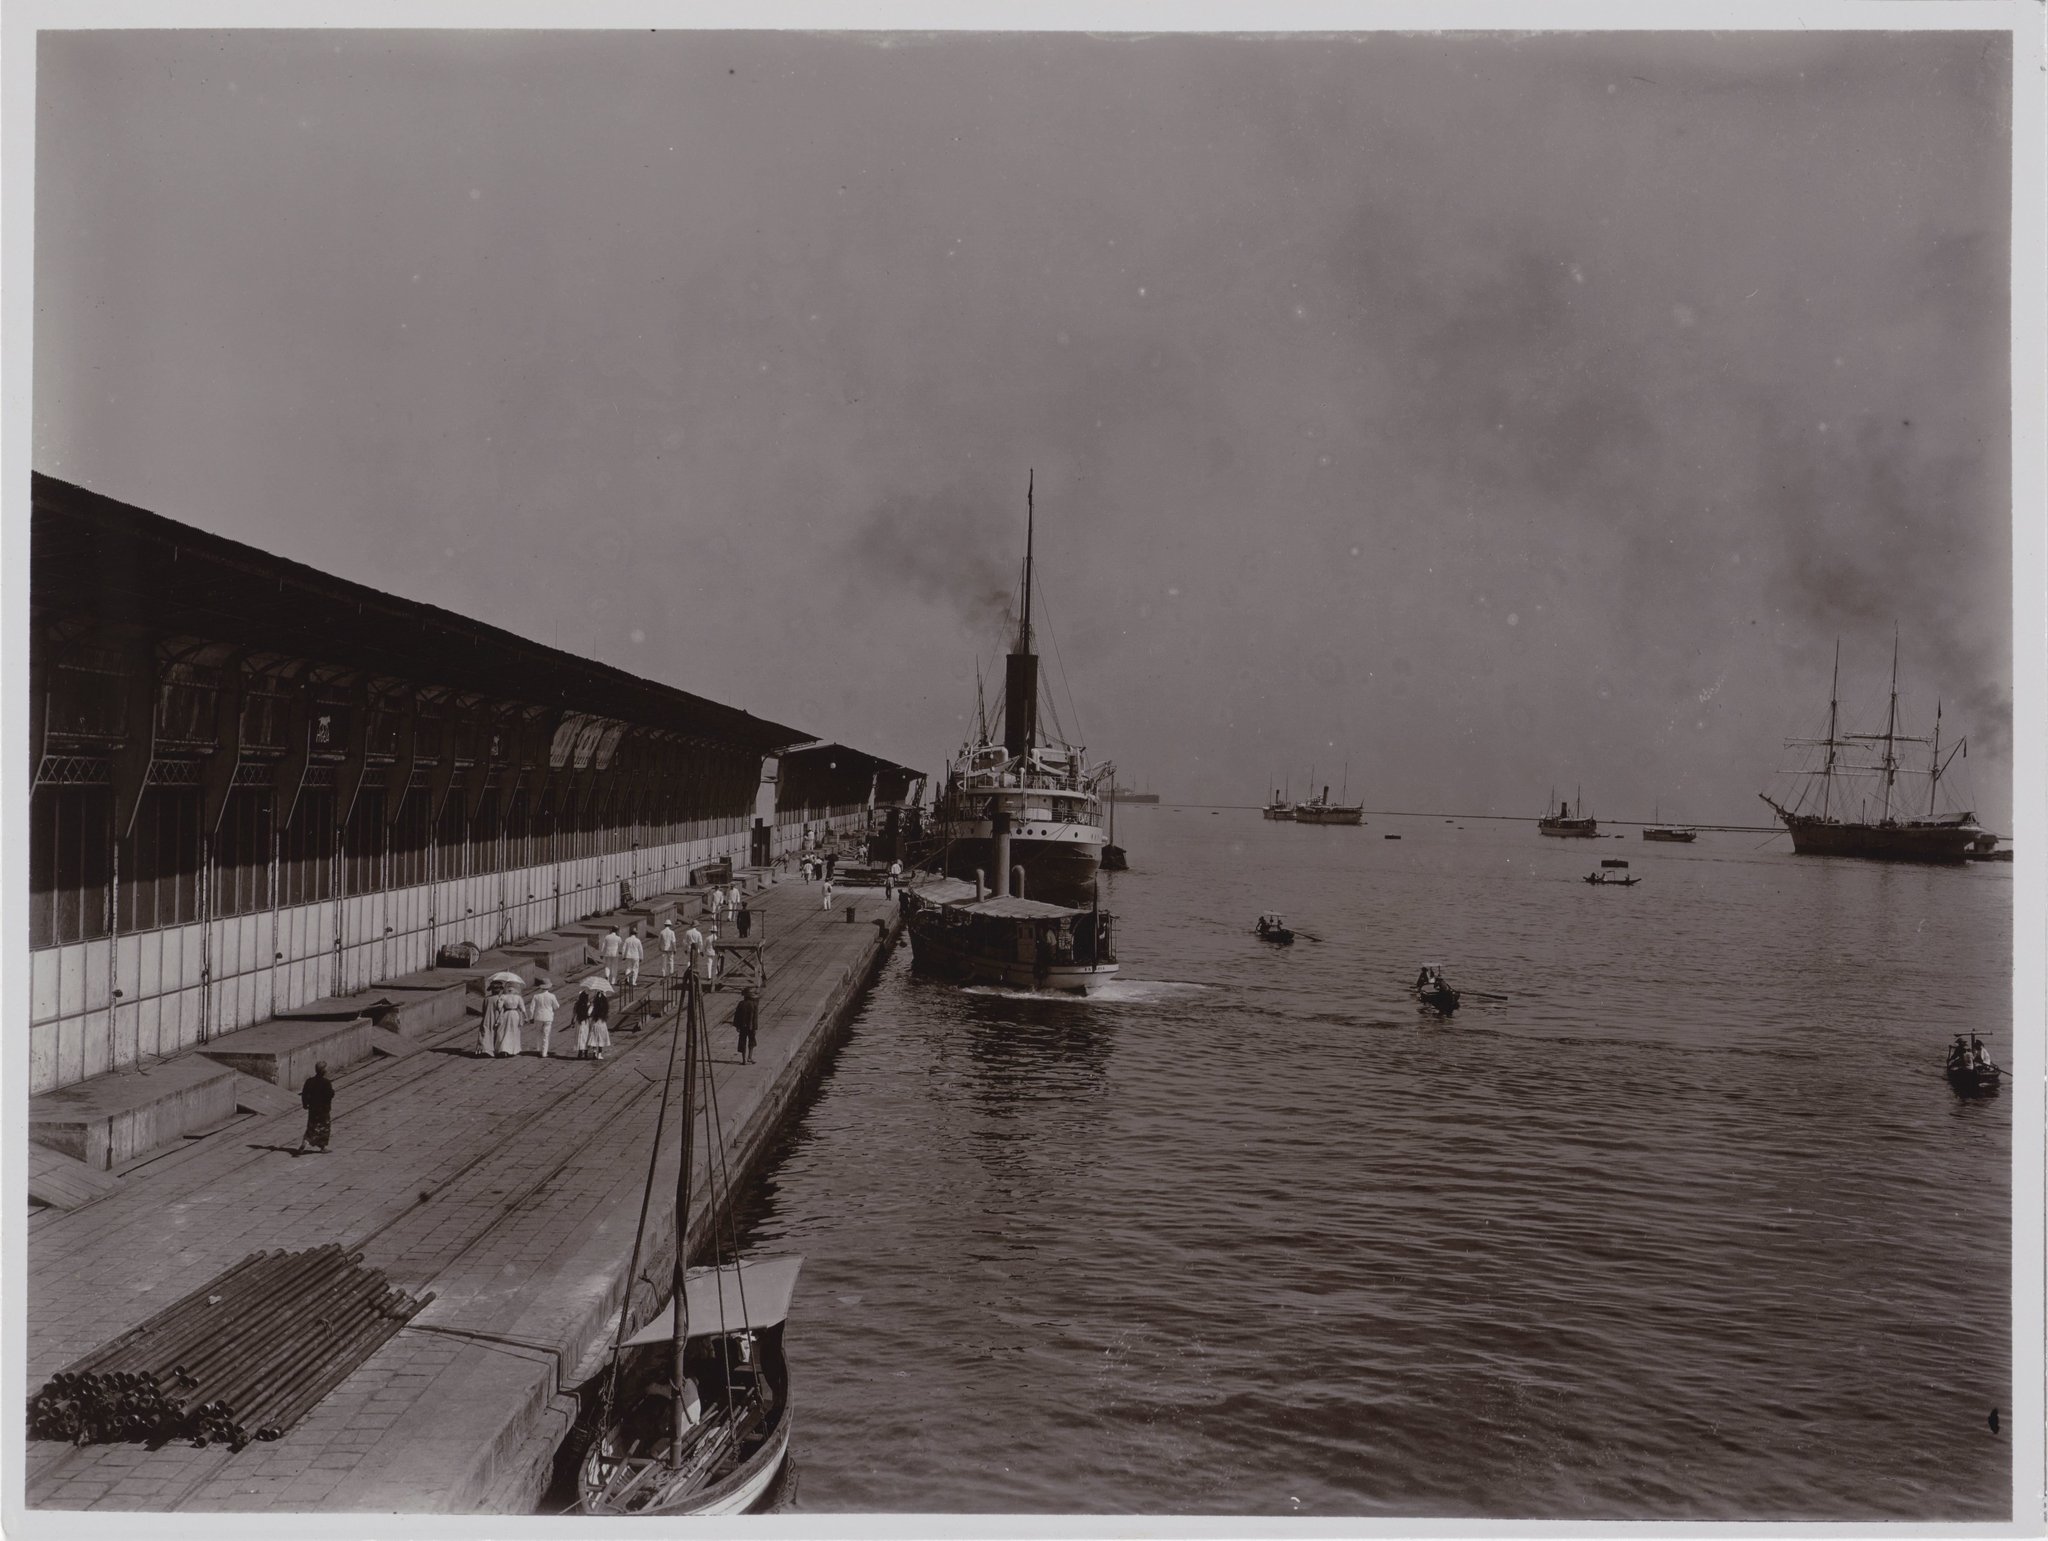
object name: photograph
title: Een reede in Indonesië met aangemeerde schepen.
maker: johanna hermina marmelstein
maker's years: 1897-1990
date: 1900-1915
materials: paper, photographic support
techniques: albumen print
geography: jakarta